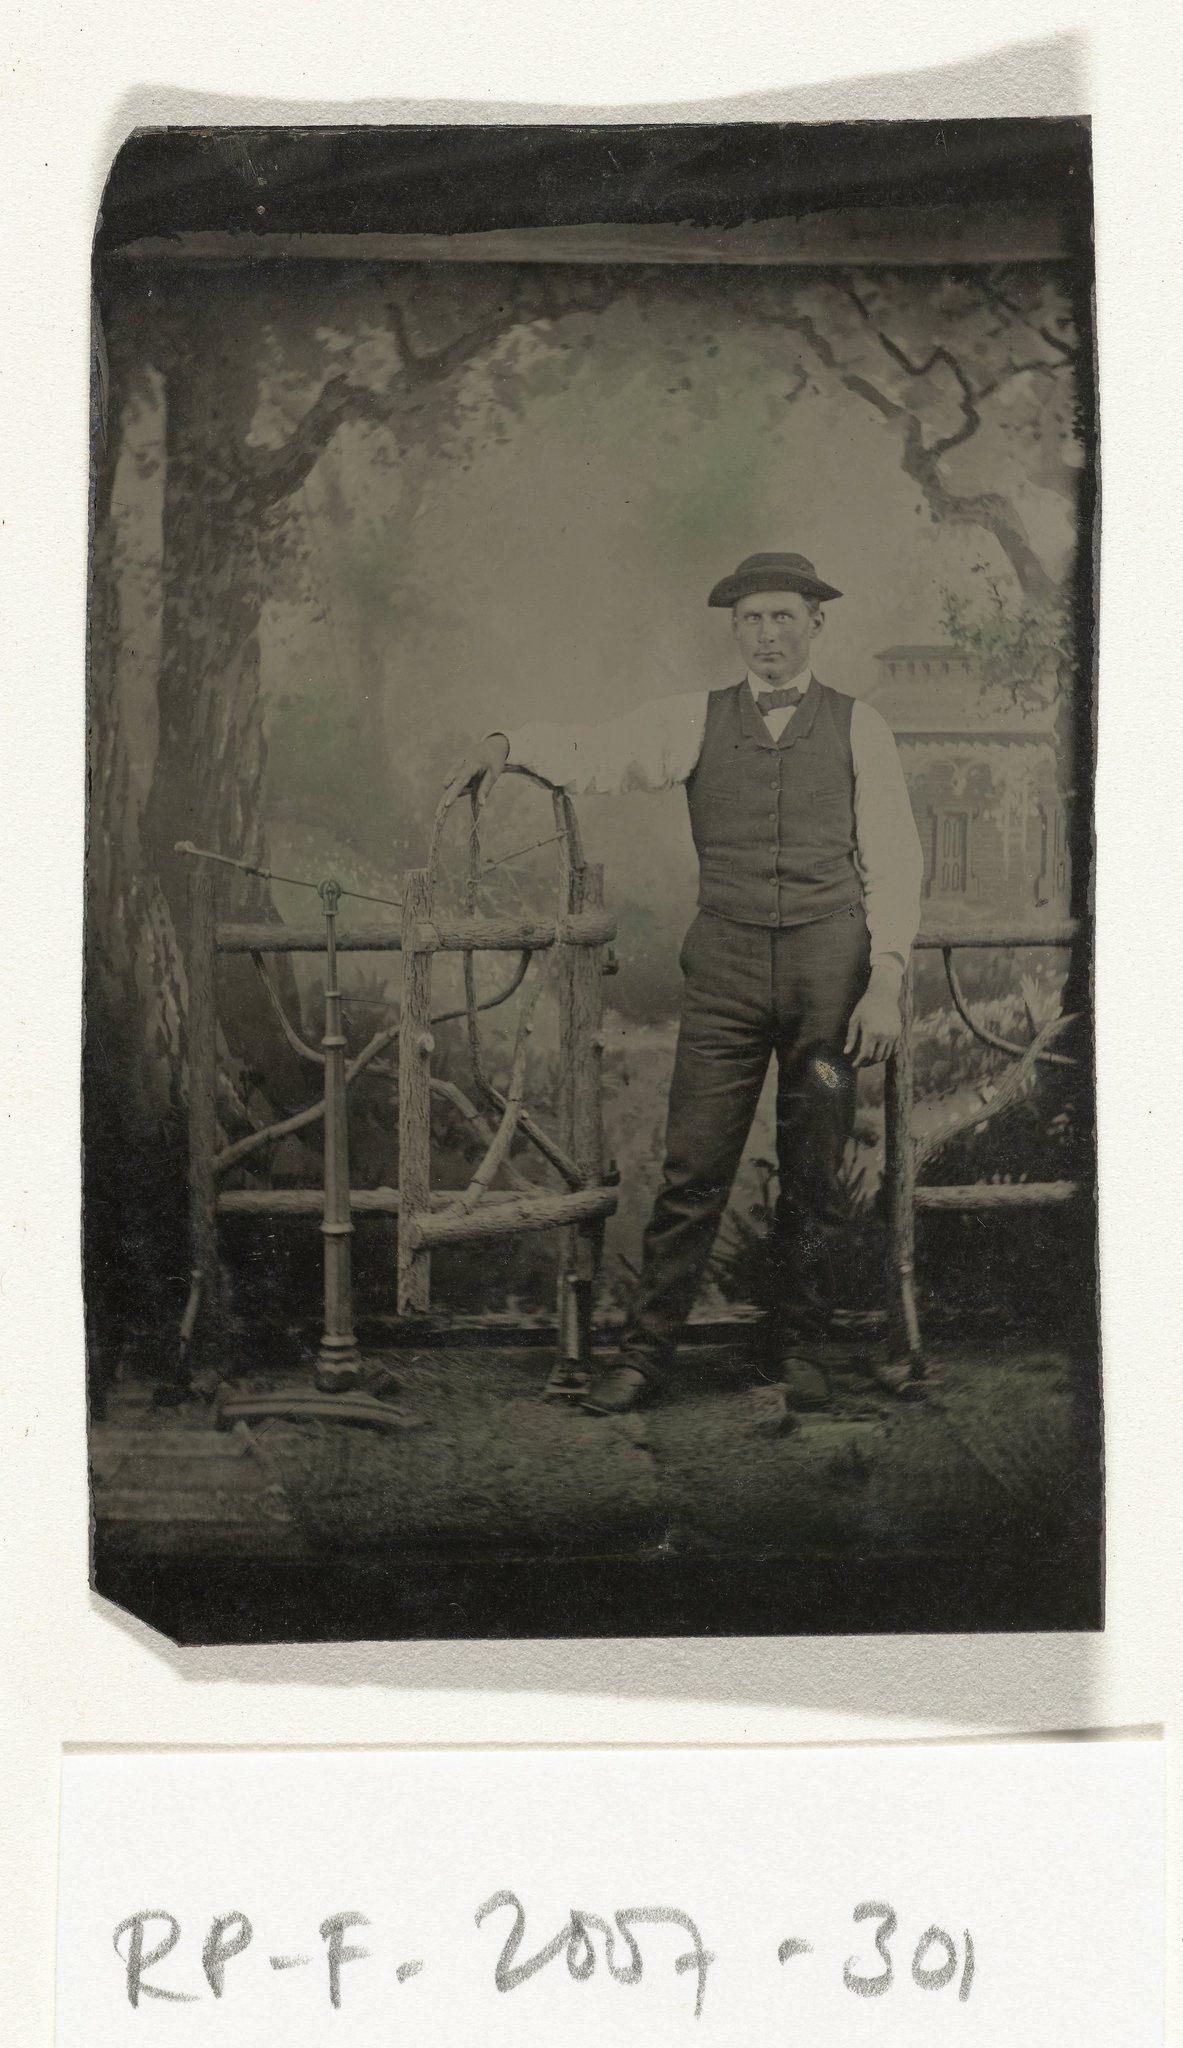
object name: photograph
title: Portret van een man, staand voor een geschilderd achtergronddoek (bos en huis) en een houten hek, met links een neksteun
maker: Anonymous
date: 1870-1900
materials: metal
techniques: ferrotyping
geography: united states